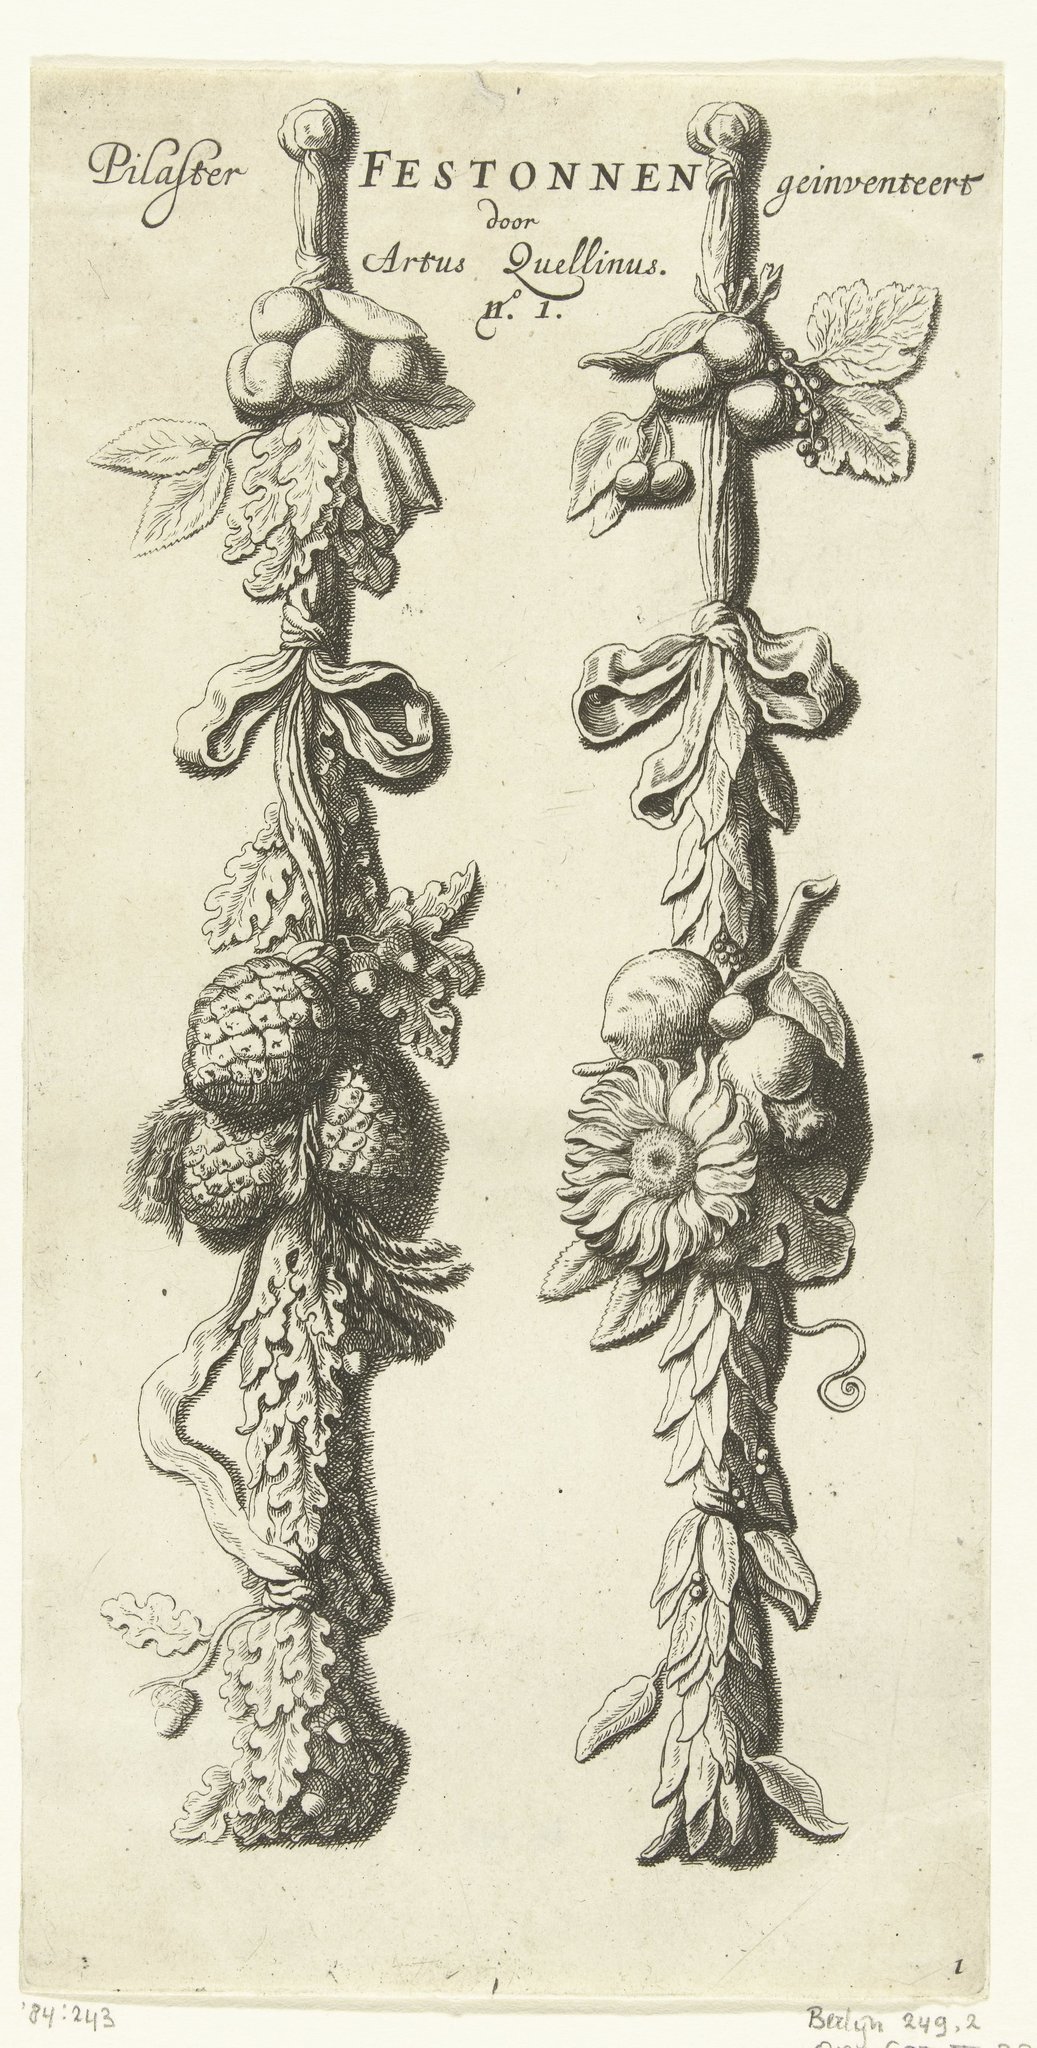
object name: ornament print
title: Pilaster Festonnen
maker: Anonymous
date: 1665-1700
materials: paper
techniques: etching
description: Tegenzijdige kopie naar prenten uitgegeven door Hubertus Quellinus en prenten uitgegeven door Johannes de Ram. Festoenen in het stadhuis van Amsterdam.